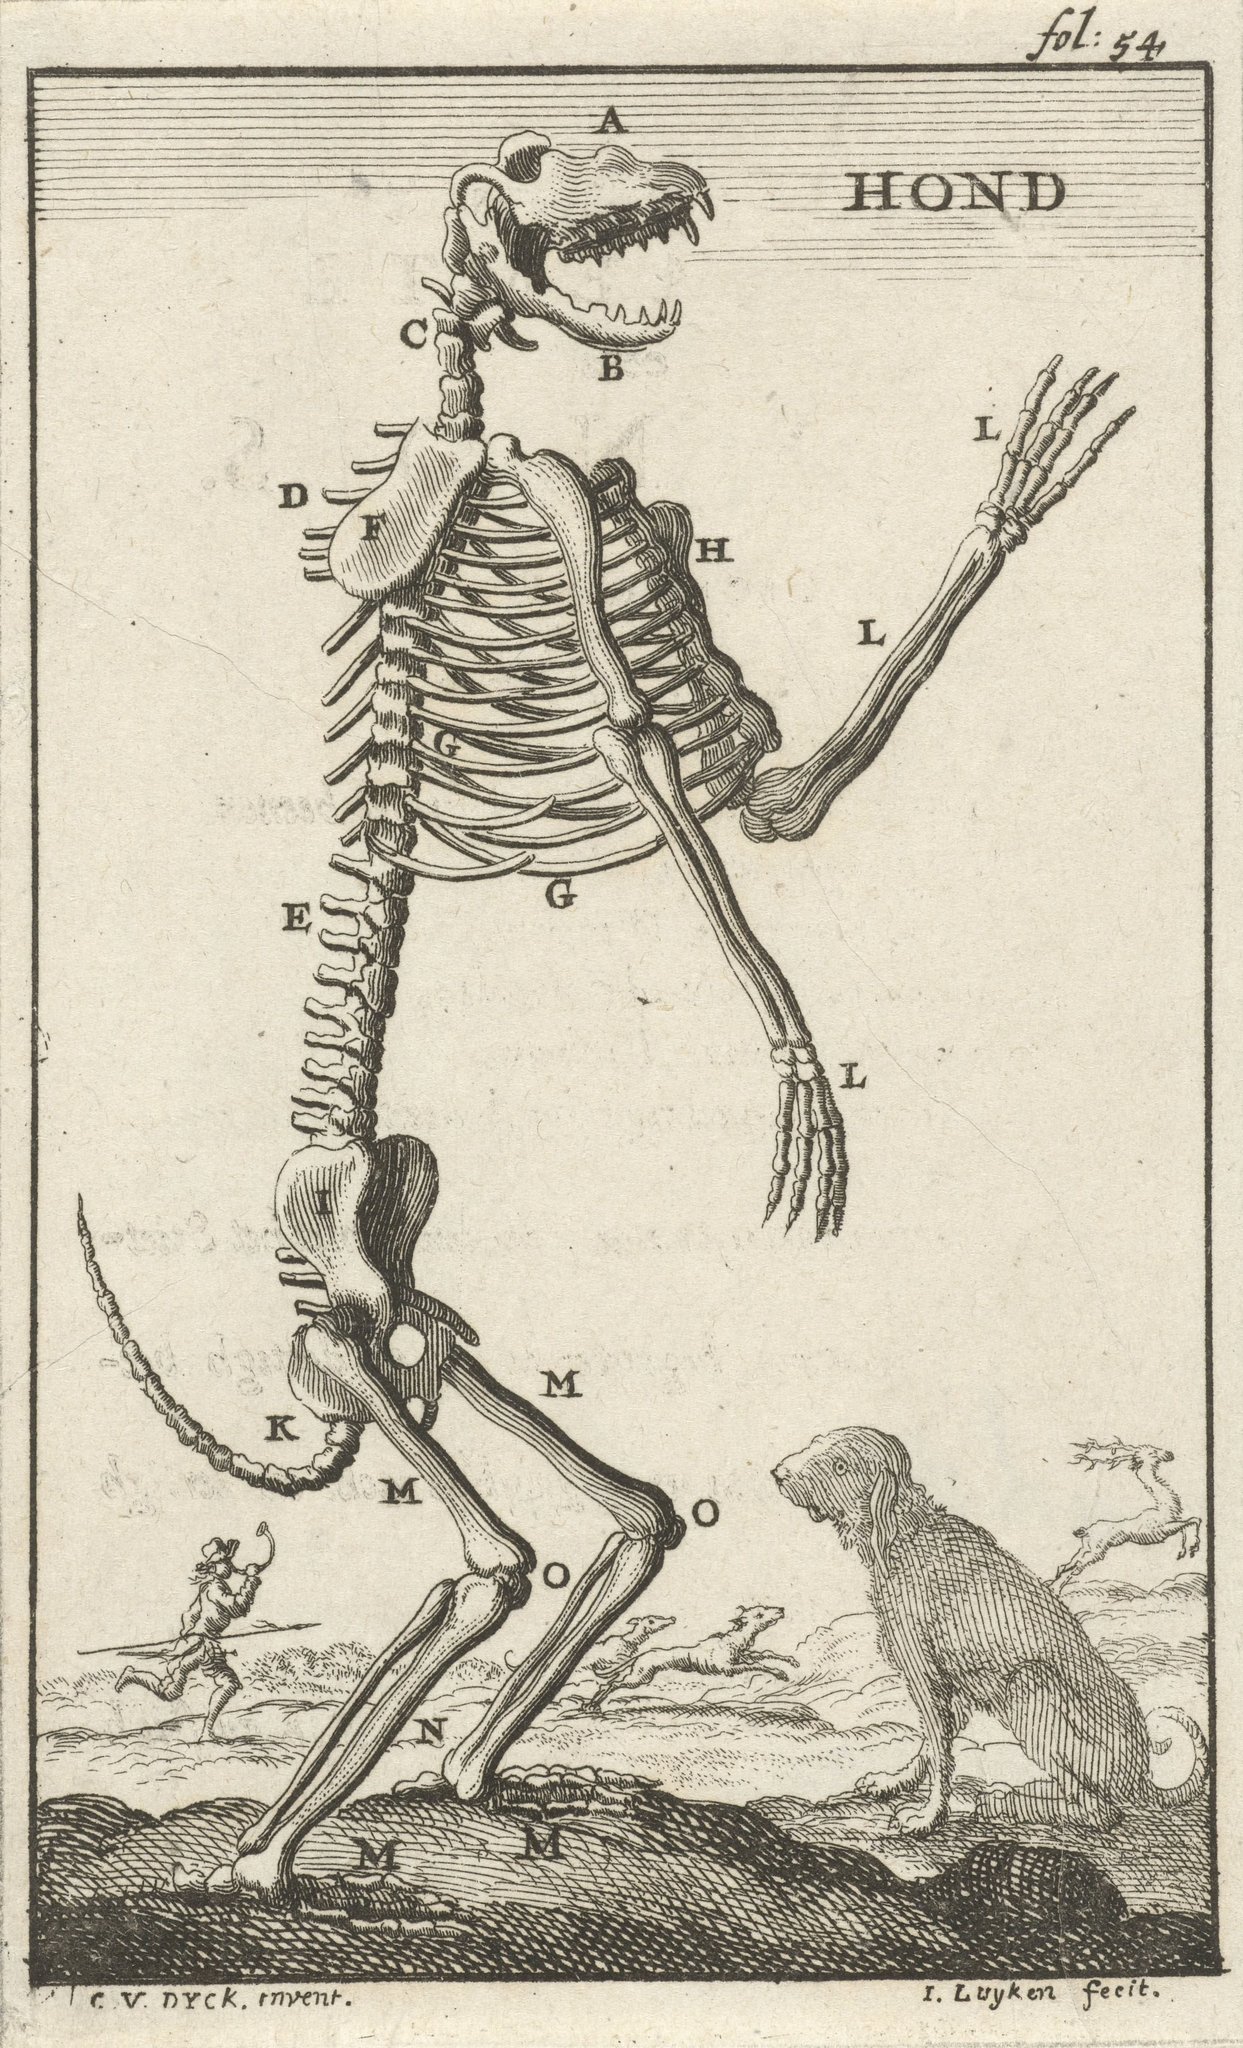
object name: book illustration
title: Geraamte van een hond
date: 1680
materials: paper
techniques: etching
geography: amsterdam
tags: animals (+ skeleton of an animal), dog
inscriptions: collector's mark: Lugt 2228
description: Illustratie opgenomen in: Dyk, Cornelis van. Osteologia, of nauwkeurige geraamt beschryving van verscheyde dieren, nevens hare historien. Amsterdam: Jan Claesz ten Hoorn, 1680.